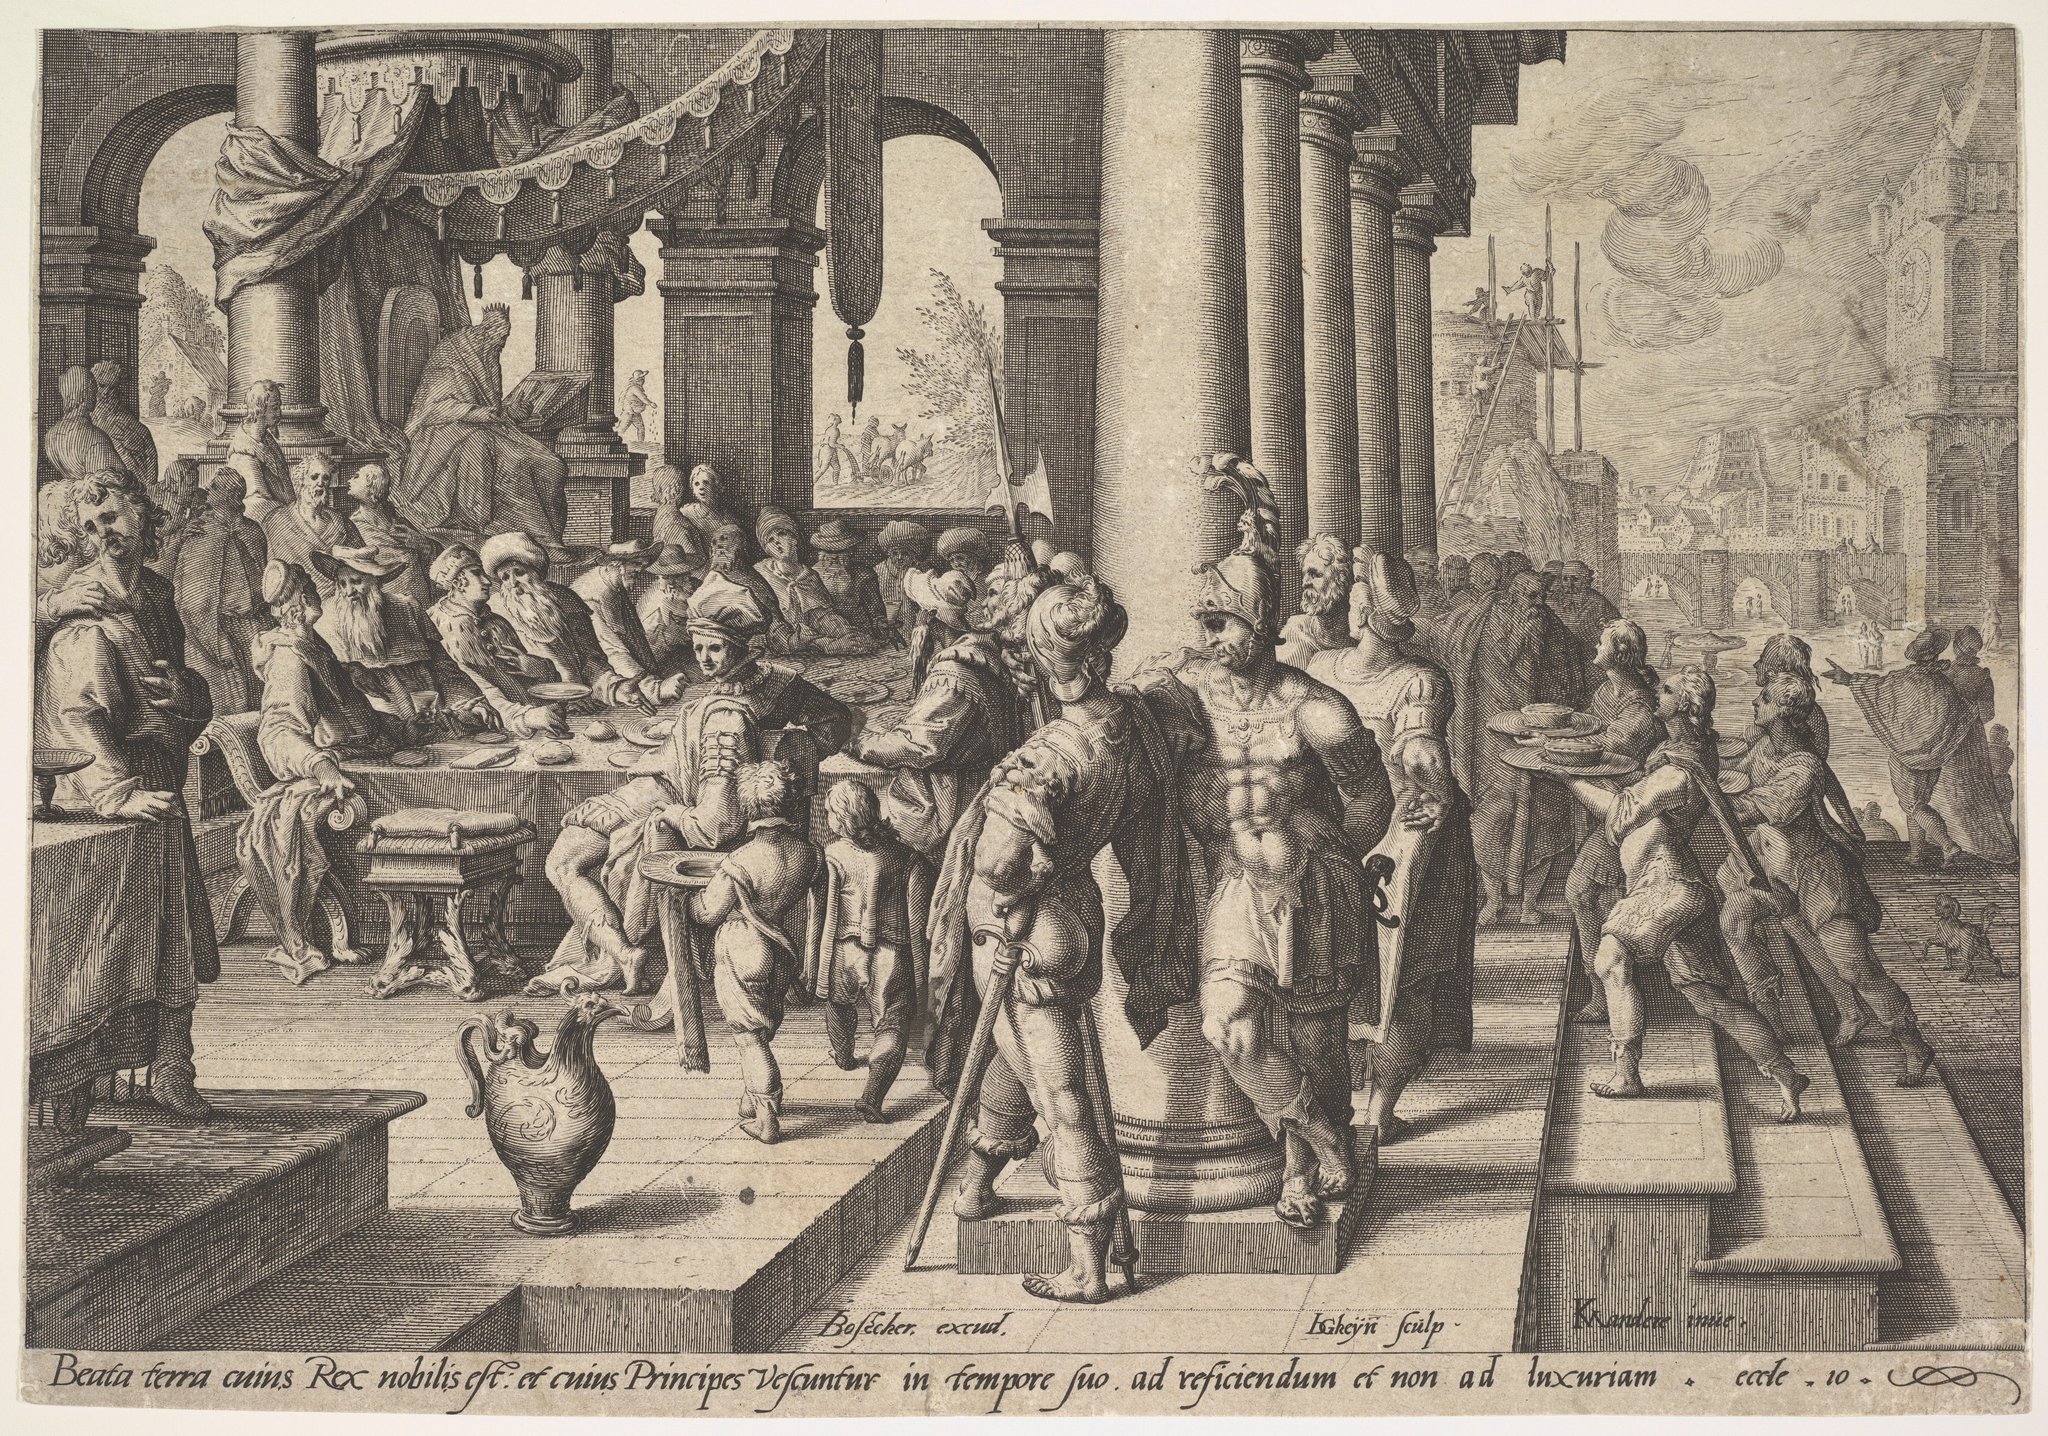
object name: print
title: Allegory of the Government of a Wise King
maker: jacques de gheyn (ii)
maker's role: artist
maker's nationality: netherlandish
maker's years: 1565-1629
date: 1588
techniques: engraving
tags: soldiers,swords,kings